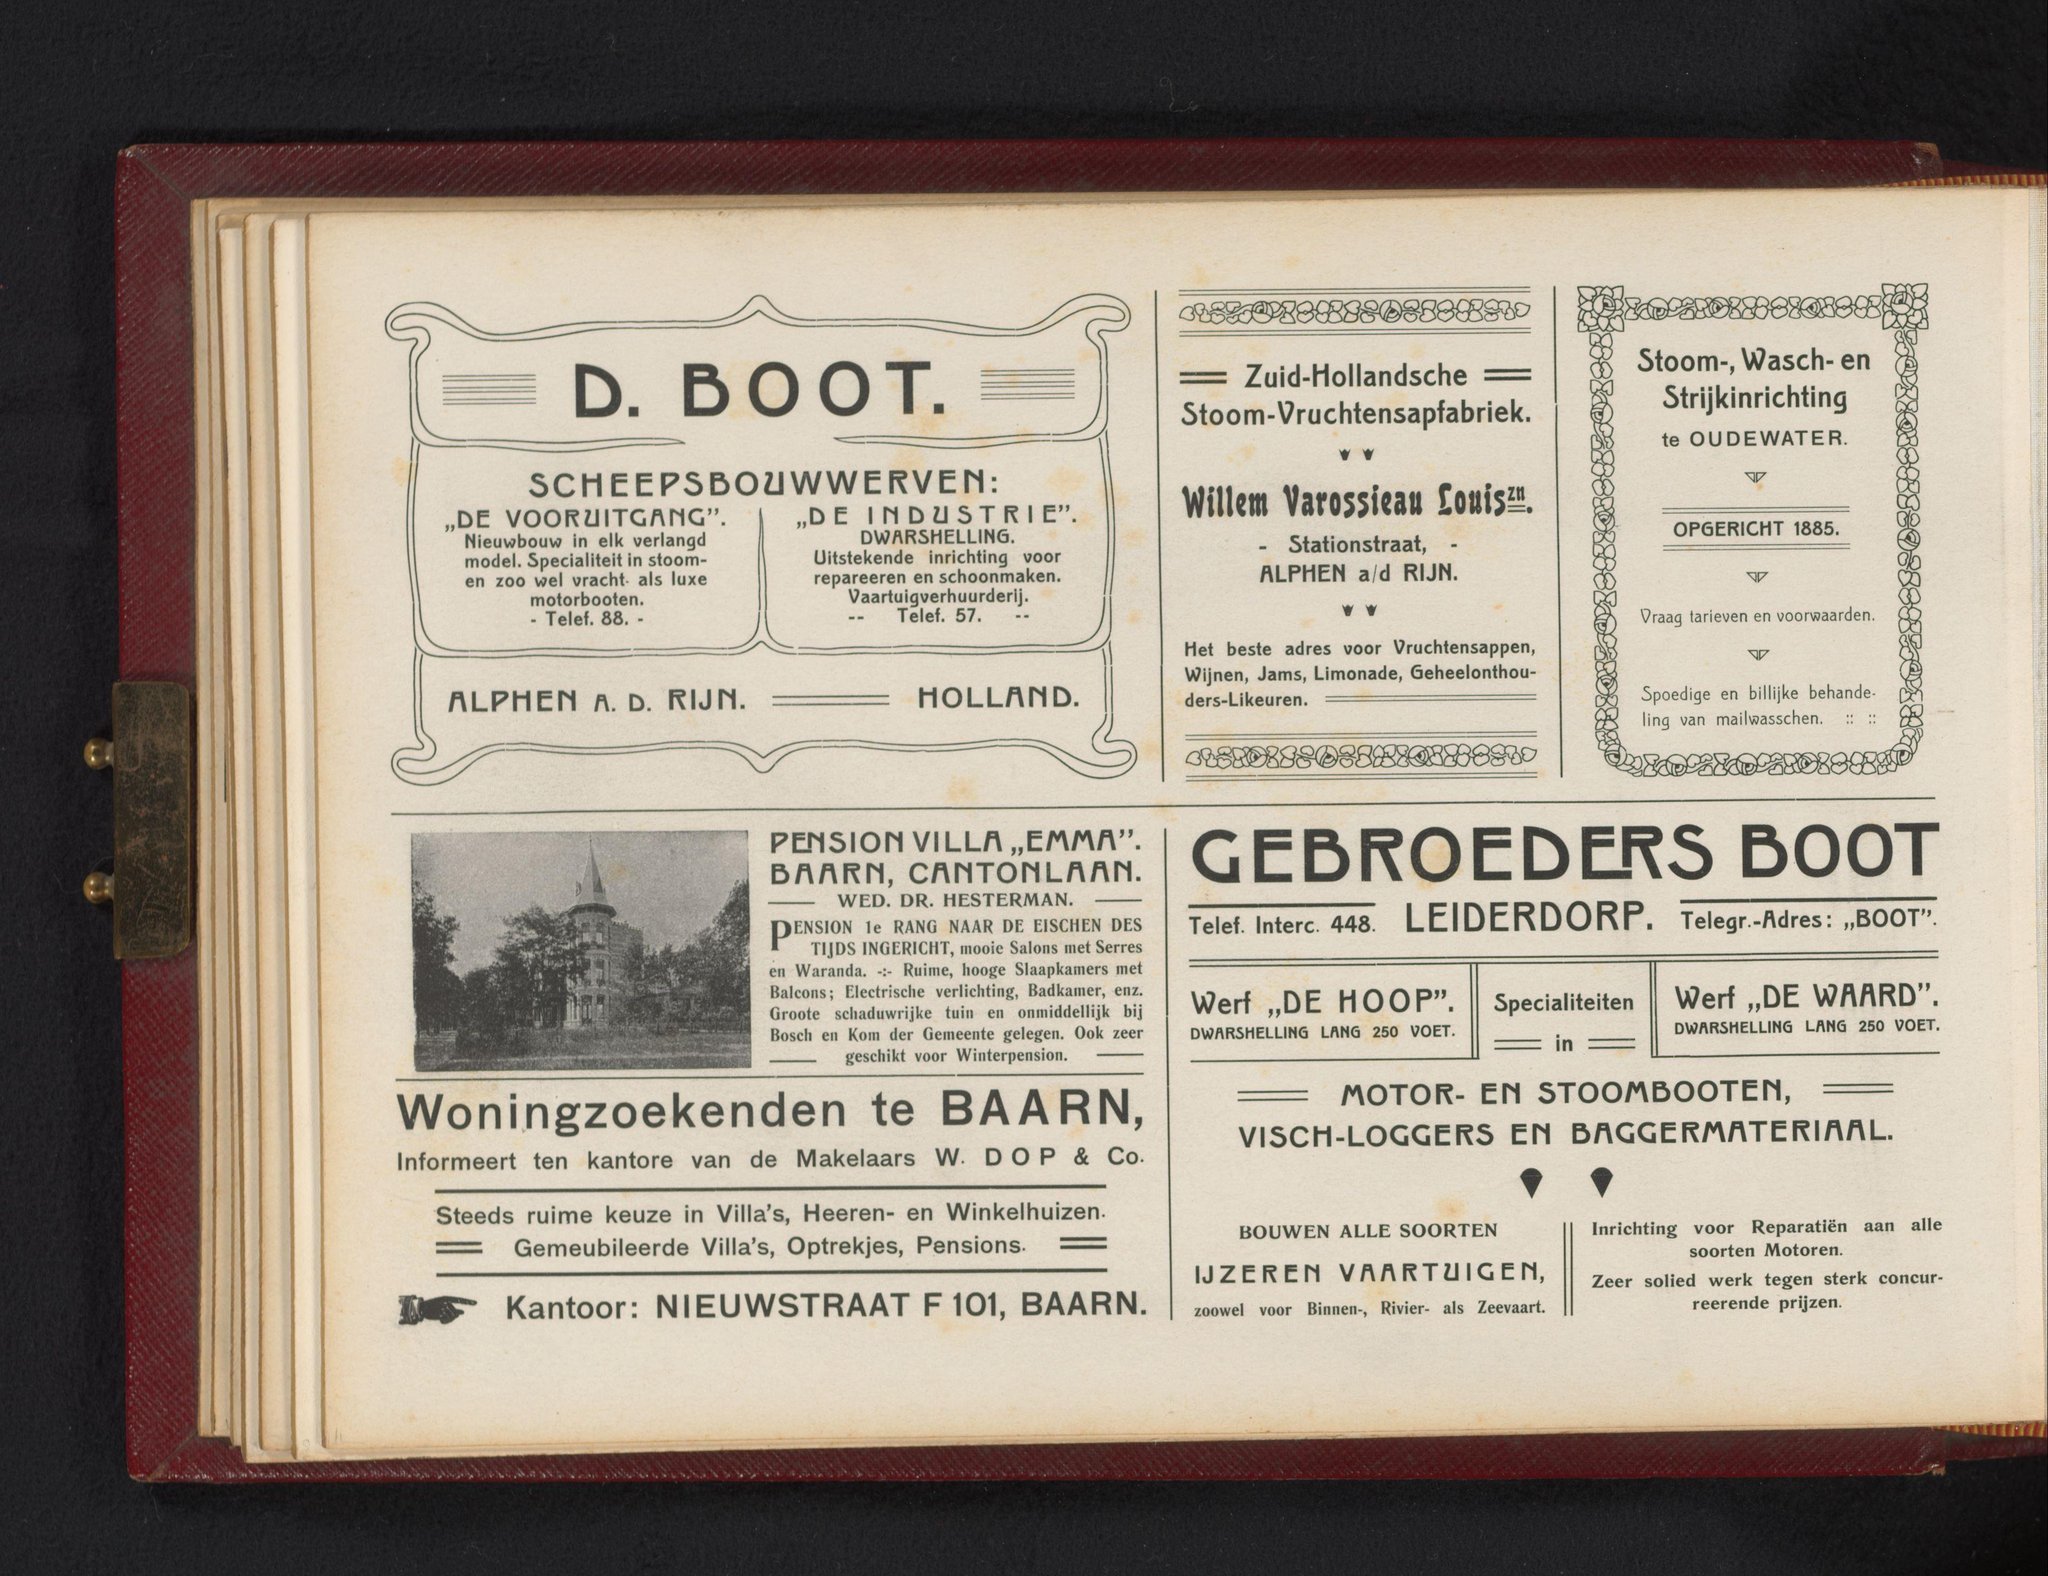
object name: album leaf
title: Advertenties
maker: Anonymous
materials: paper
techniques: printing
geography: netherlands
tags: advertising, castle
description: Advertenties voor onder andere D. Boot, Zuid-Hollansche Stoom-Vruchtensapfabriek, Stoom-Wasch- en Strijkinrichting, Makelaars W. Dop & Co en de Gebroeders Boot. Deze pagina maakt deel uit van een album.